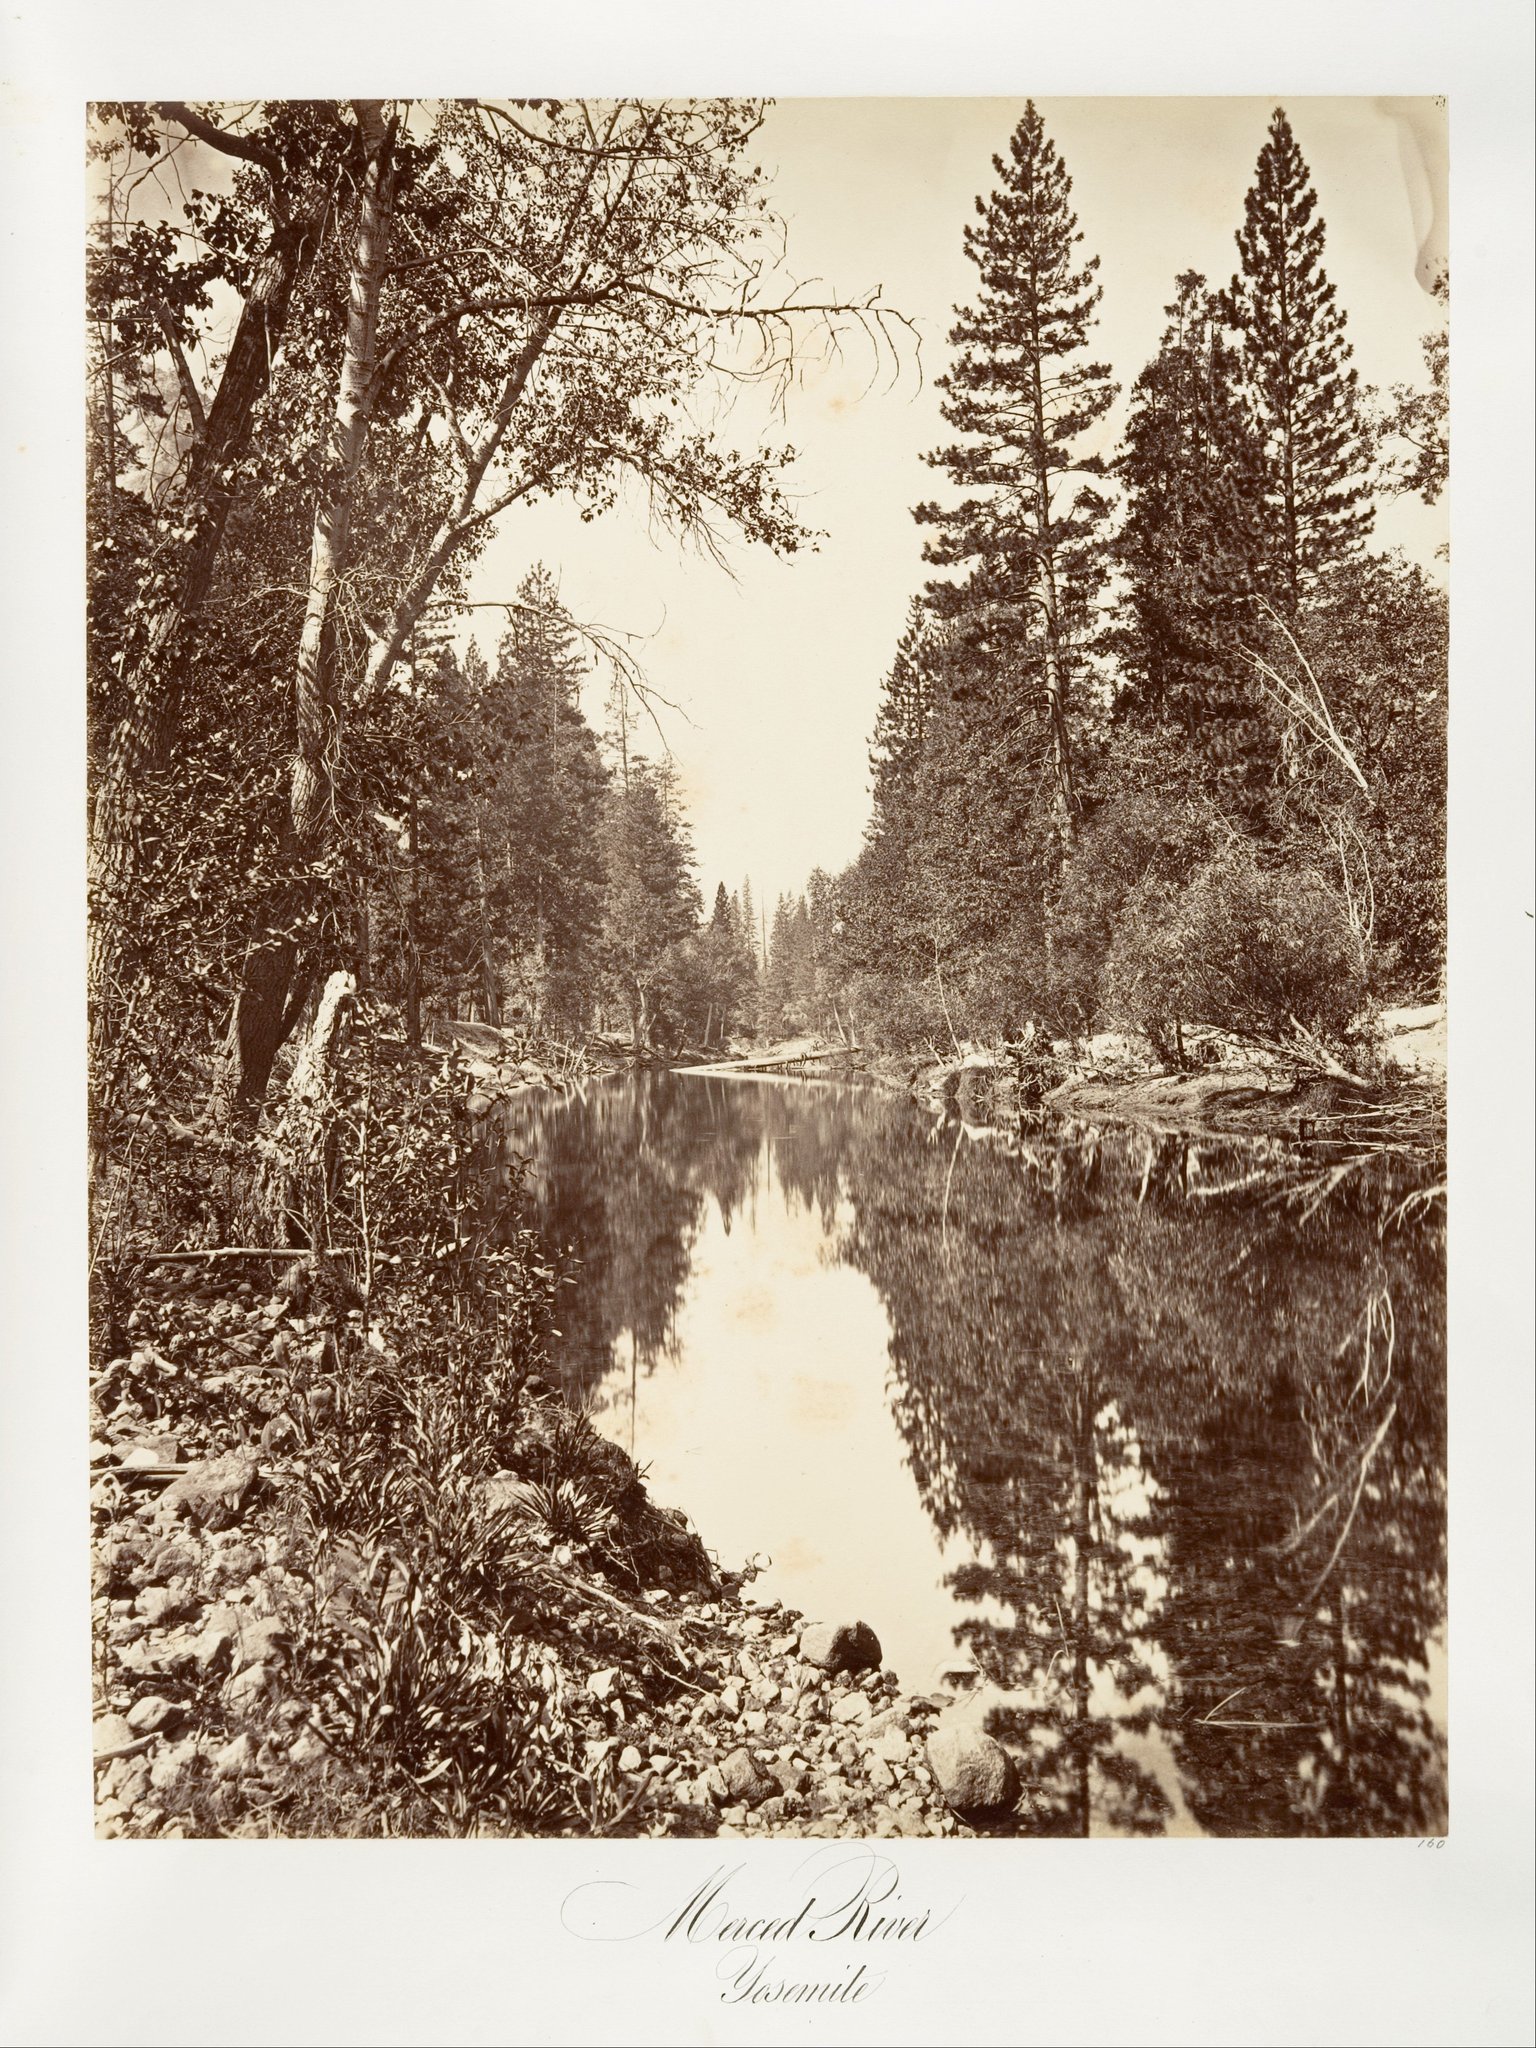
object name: photograph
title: Merced River, Yosemite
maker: carleton e. watkins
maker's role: artist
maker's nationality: american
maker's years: 1829-1916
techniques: albumen silver print, glass negative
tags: rivers,forests